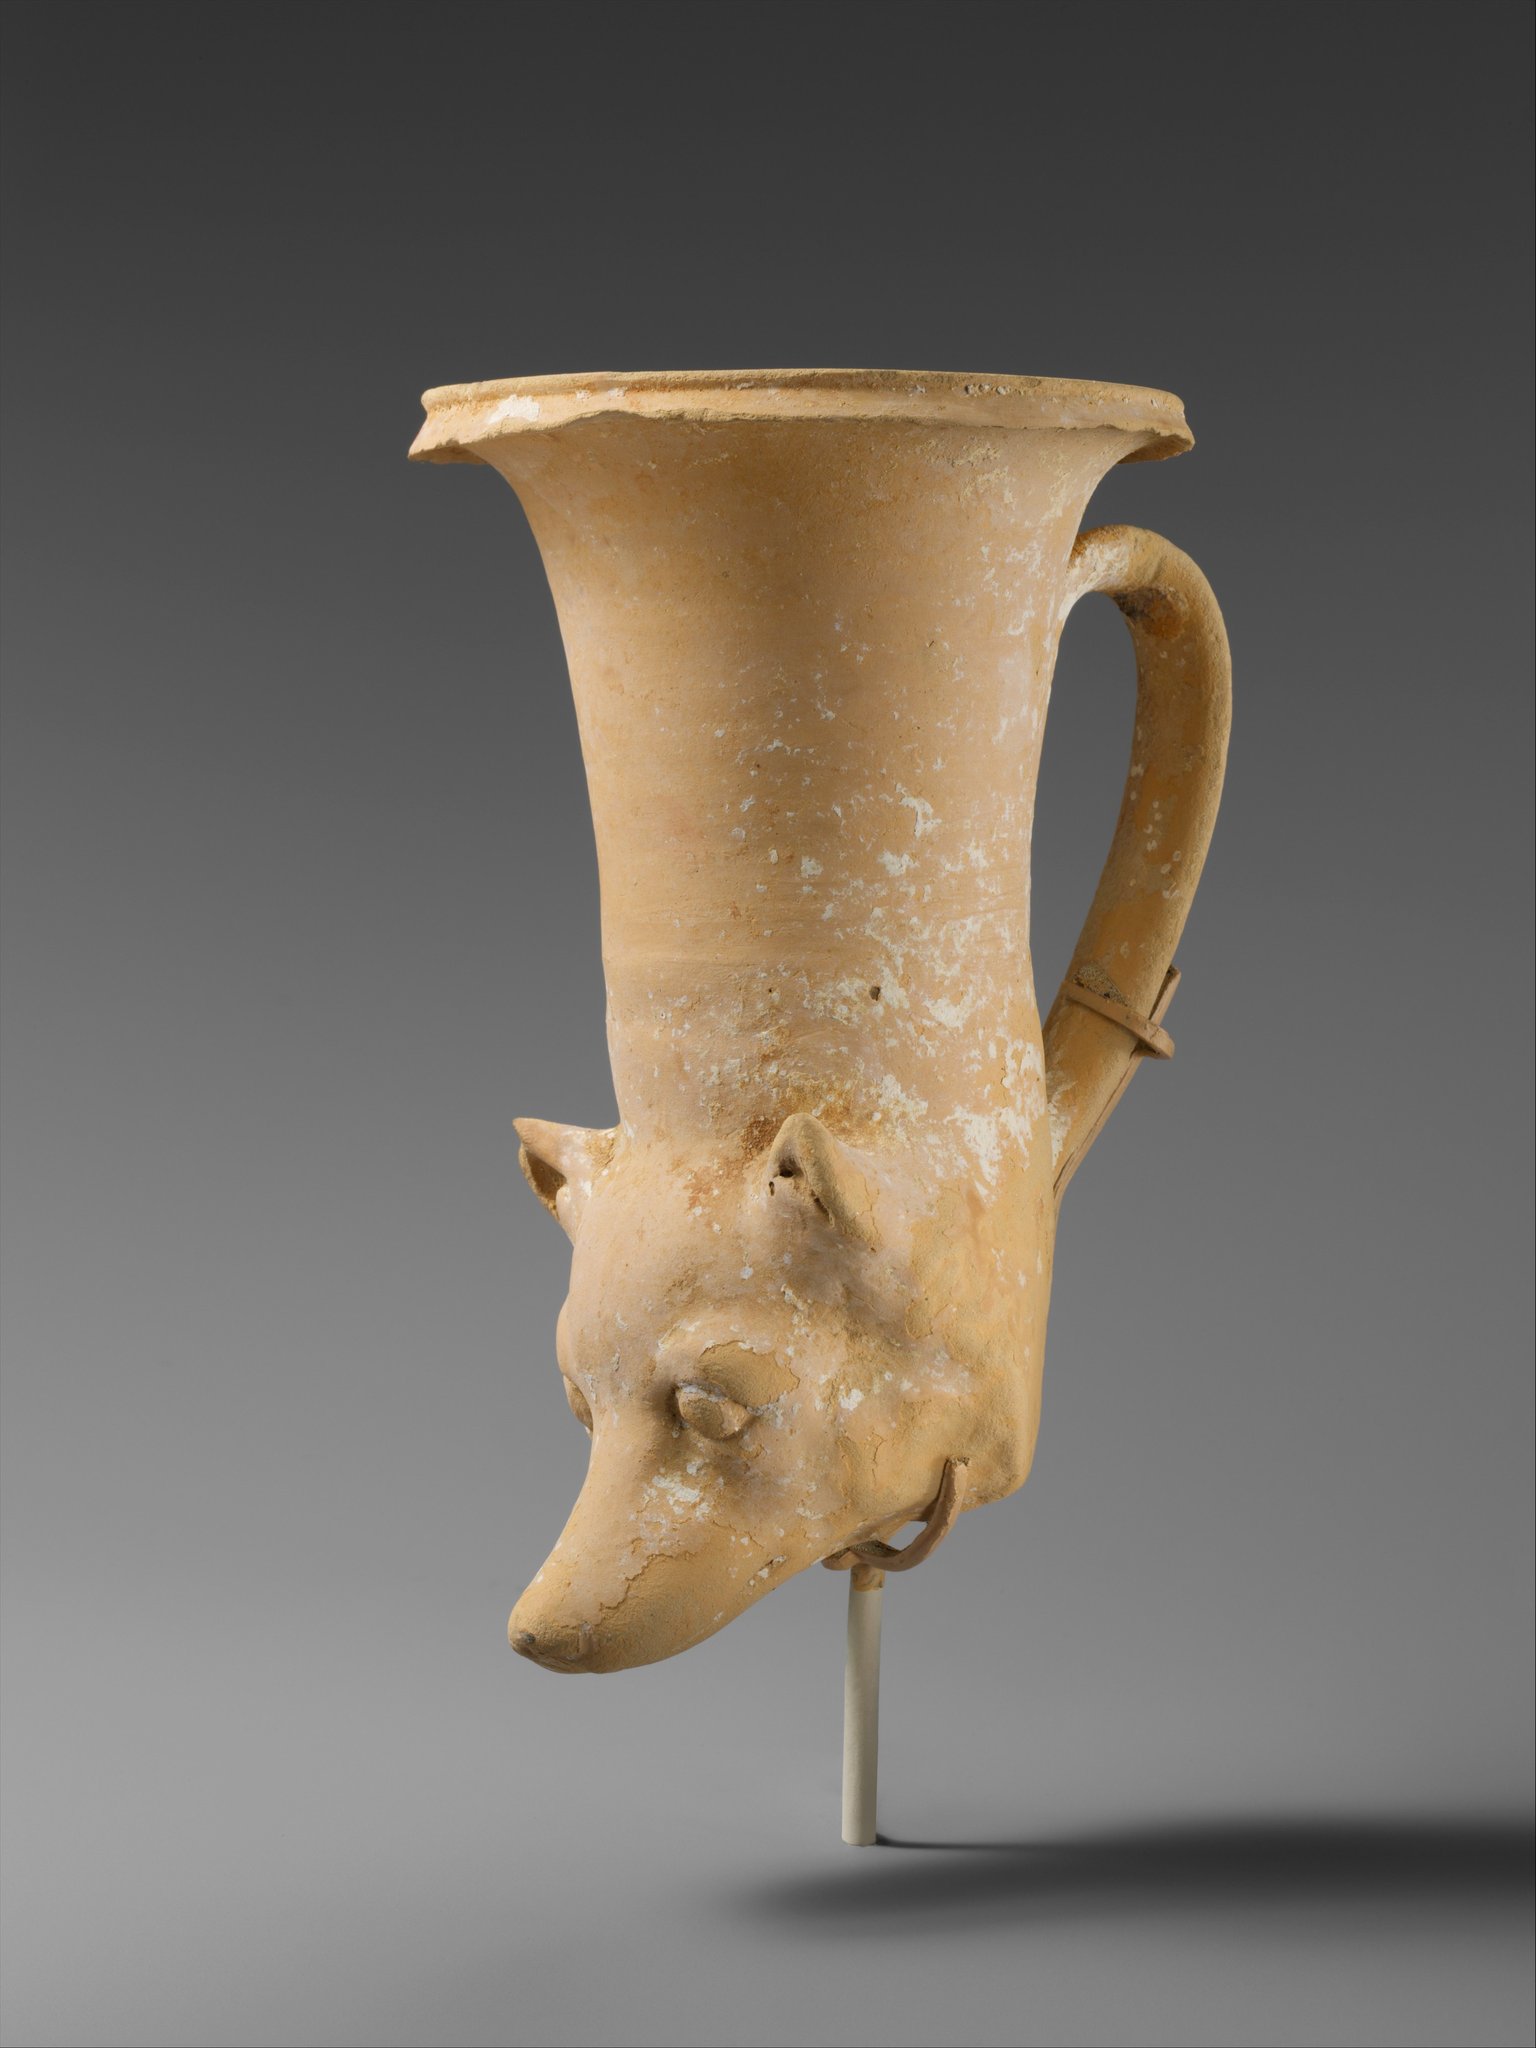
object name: rhyton in the form of a dog's head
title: Terracotta rhyton (vase for libations or drinking)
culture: greek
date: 334-268 BCE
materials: terracotta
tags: dogs